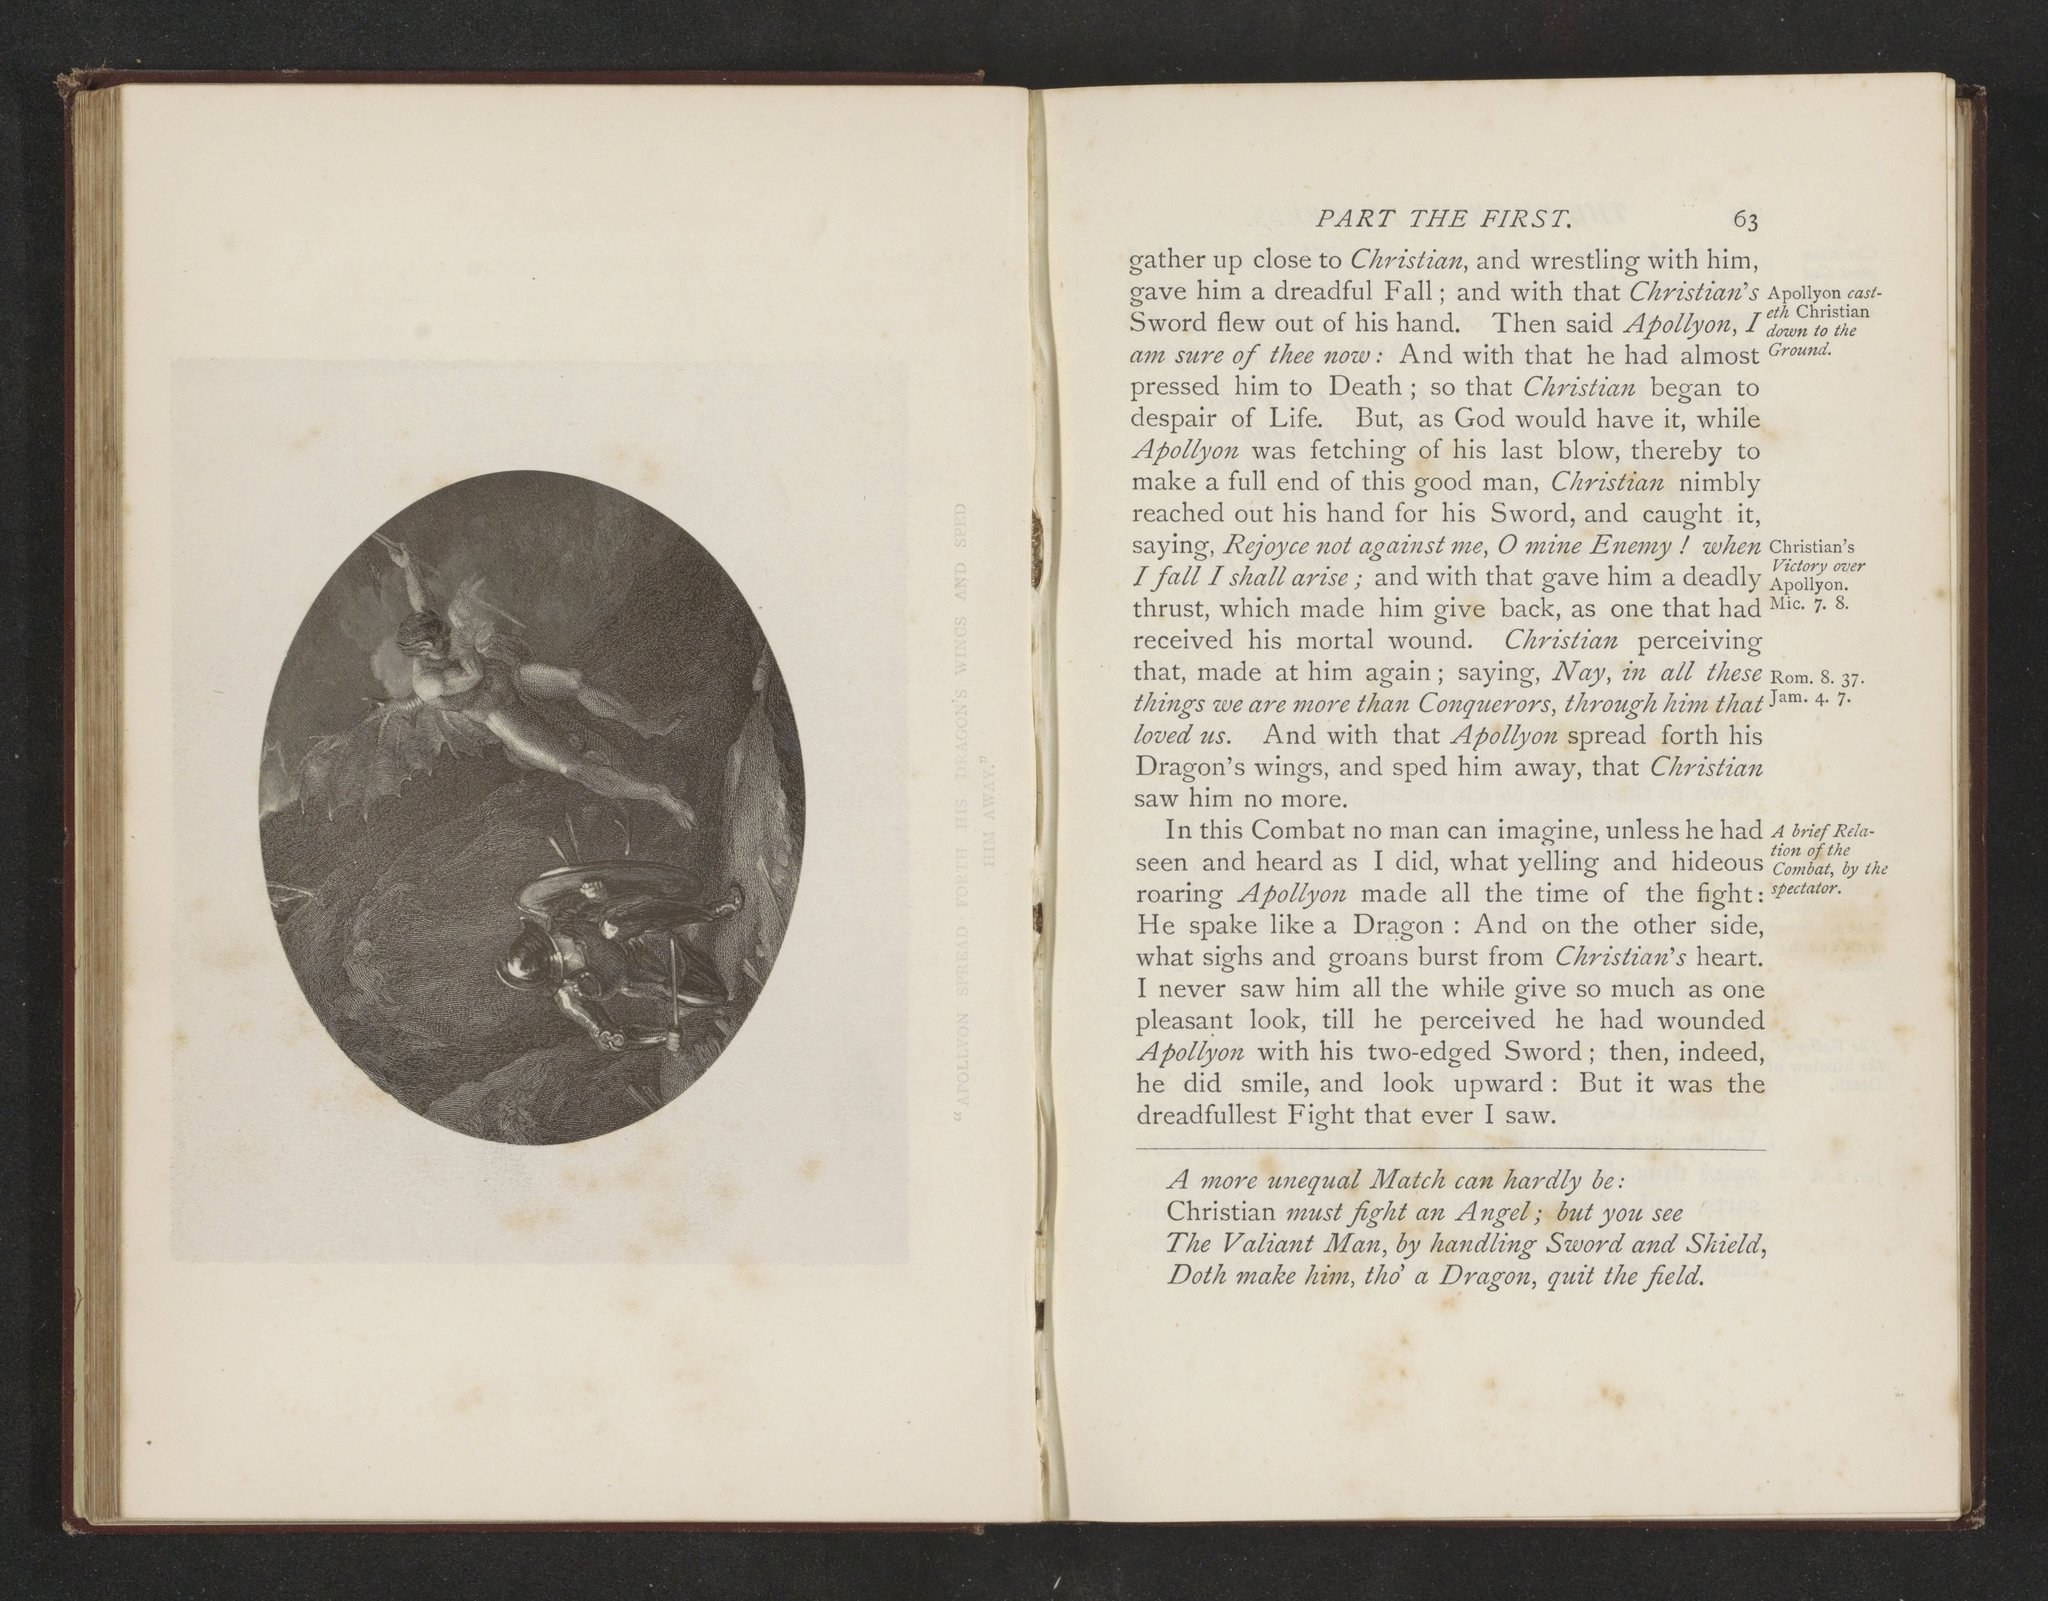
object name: page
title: “Apollyon spread forth his Dragon's Wings and sped Him away.”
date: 1871-1881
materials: paper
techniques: woodburytype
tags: print, e.g.: engraving, etching, lithograph, dragon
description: Illustratie betreft Christen in gevecht met Apollyon .